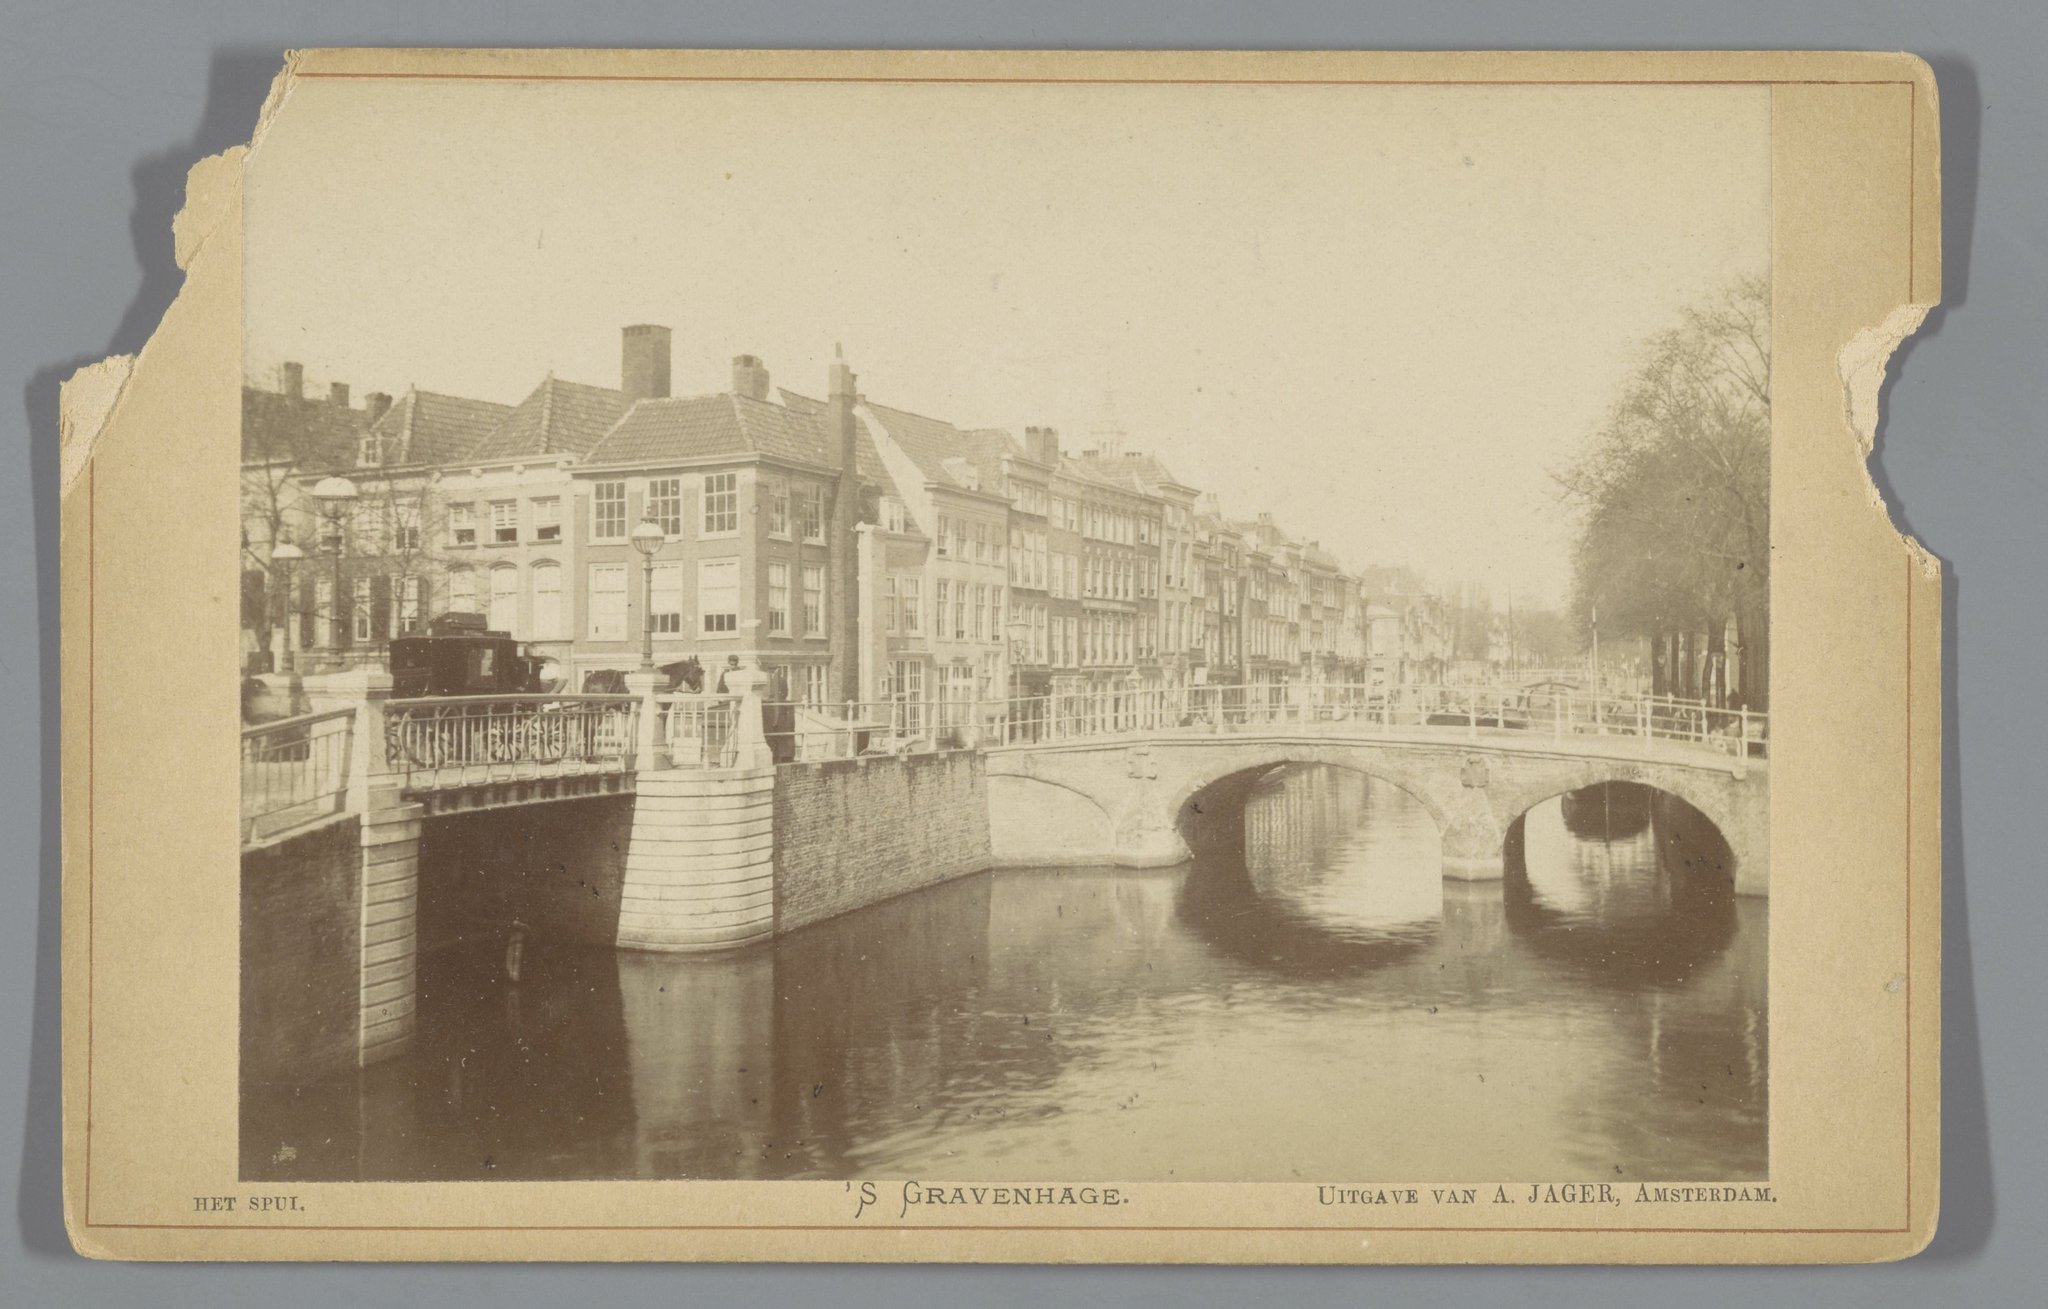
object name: cabinet photograph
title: 's Gravenhage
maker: andries jager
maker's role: publisher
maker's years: 1825-1905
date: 1860-1890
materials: cardboard, photographic support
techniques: albumen print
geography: the hague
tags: canals, waters (in city), street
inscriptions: annotation: ‘Kanalen "Spui" i Haag.’, retailer's mark: ‘M. J. VISSER Jr./ 36/ SPUISTRAAT’